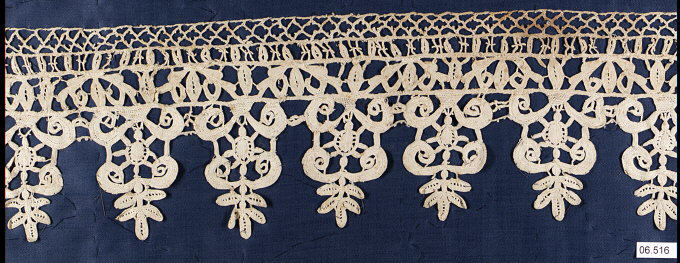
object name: strip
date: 1601-1650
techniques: lace